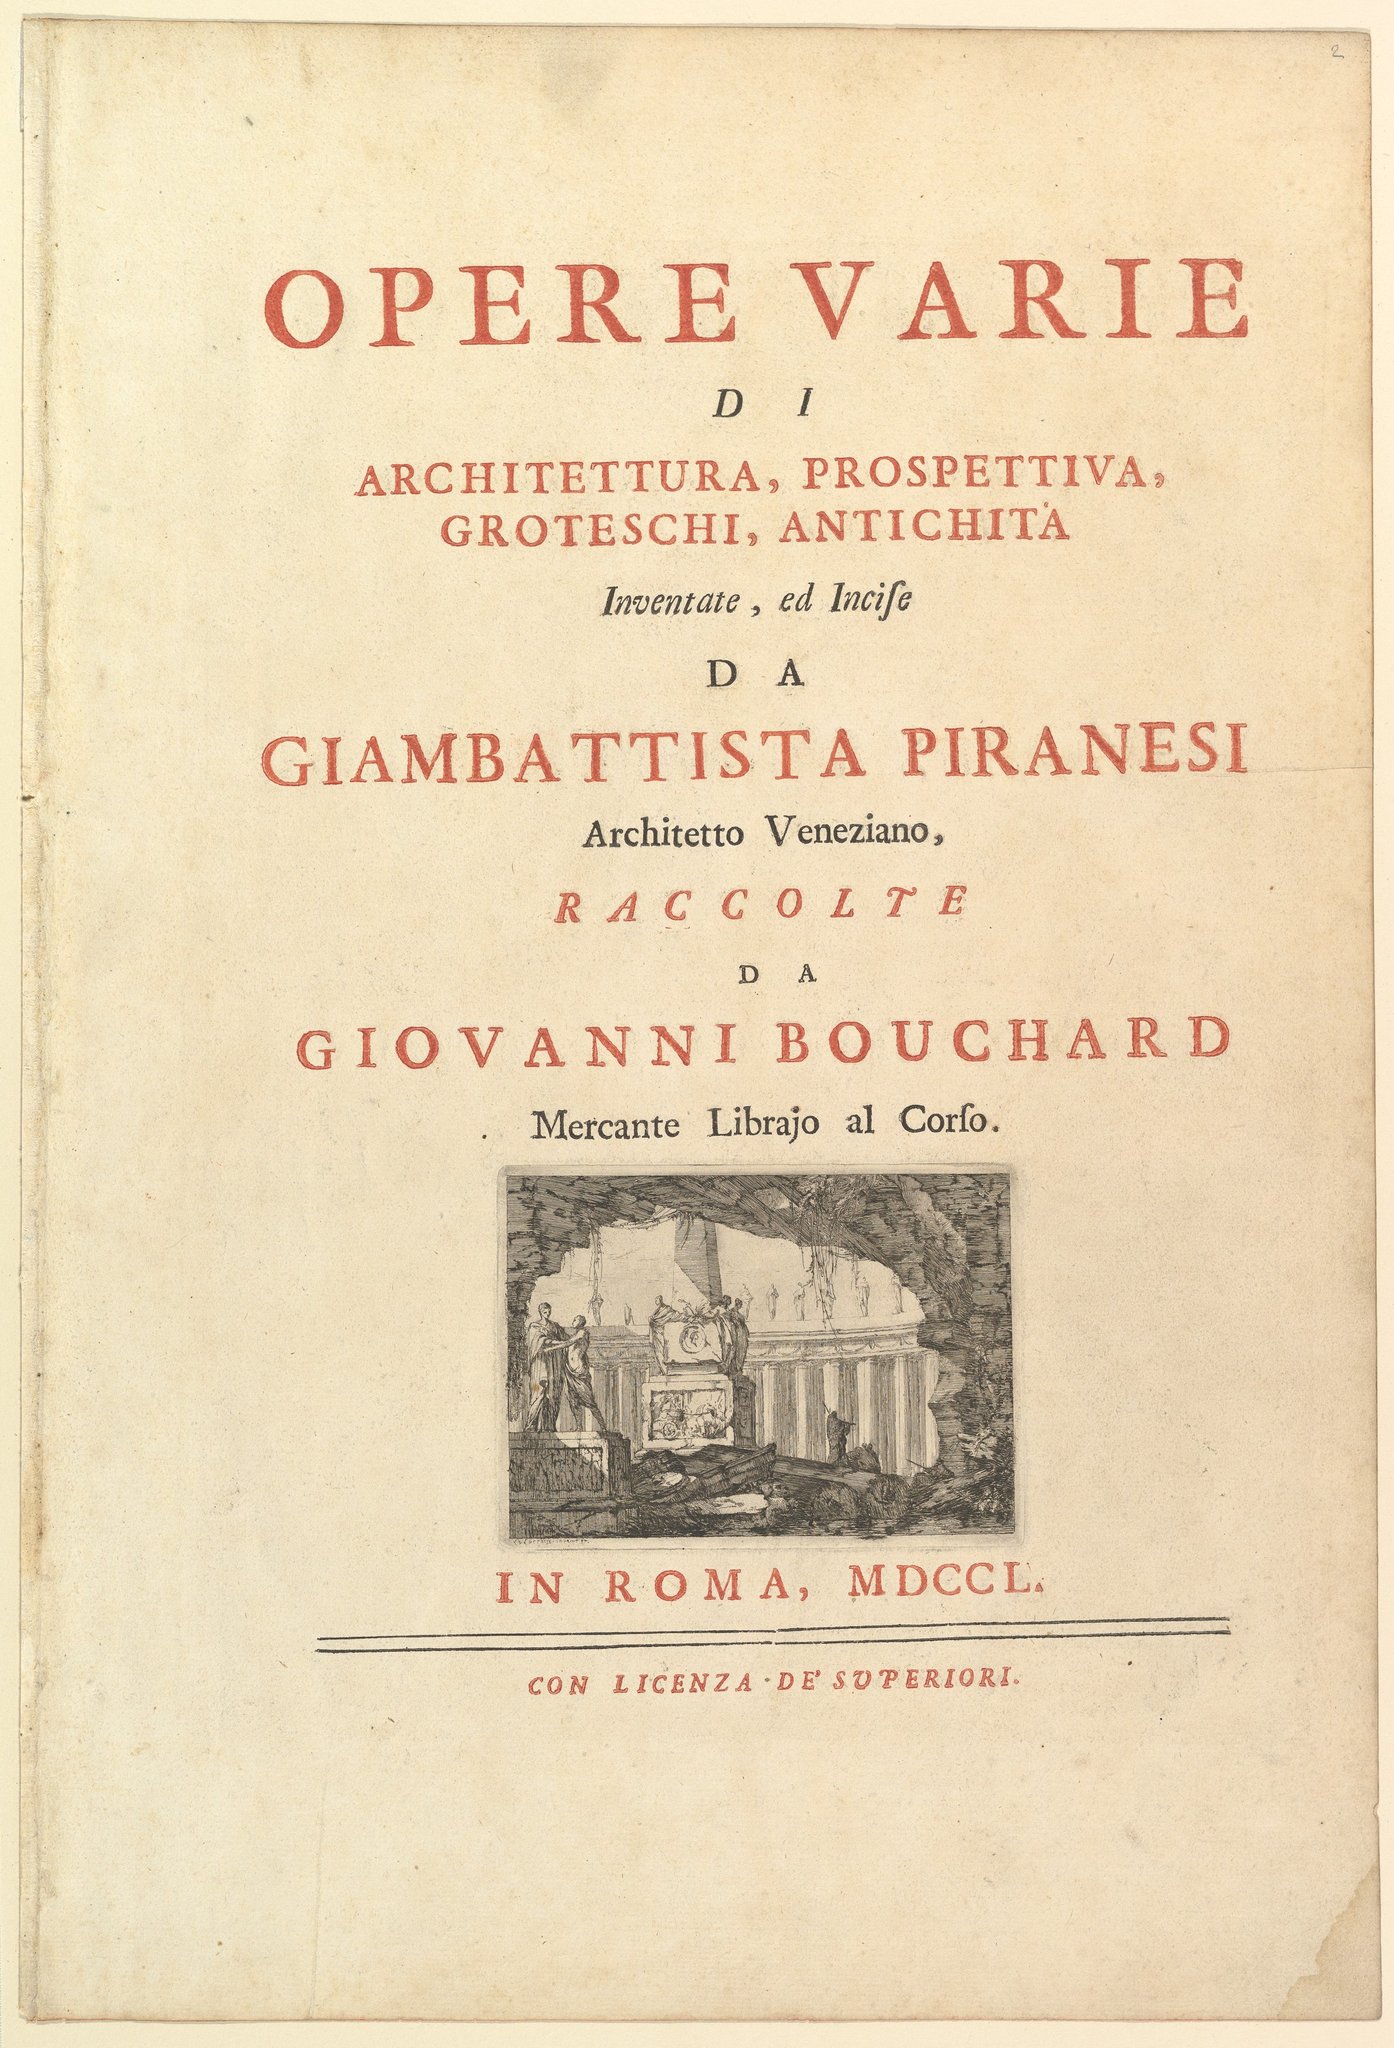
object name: print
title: Frontispiece to "Opere varie di architettura, prospettive grotesshi antichità"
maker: giovanni battista piranesi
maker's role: artist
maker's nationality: italian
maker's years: 1720-1778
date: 1750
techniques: etching